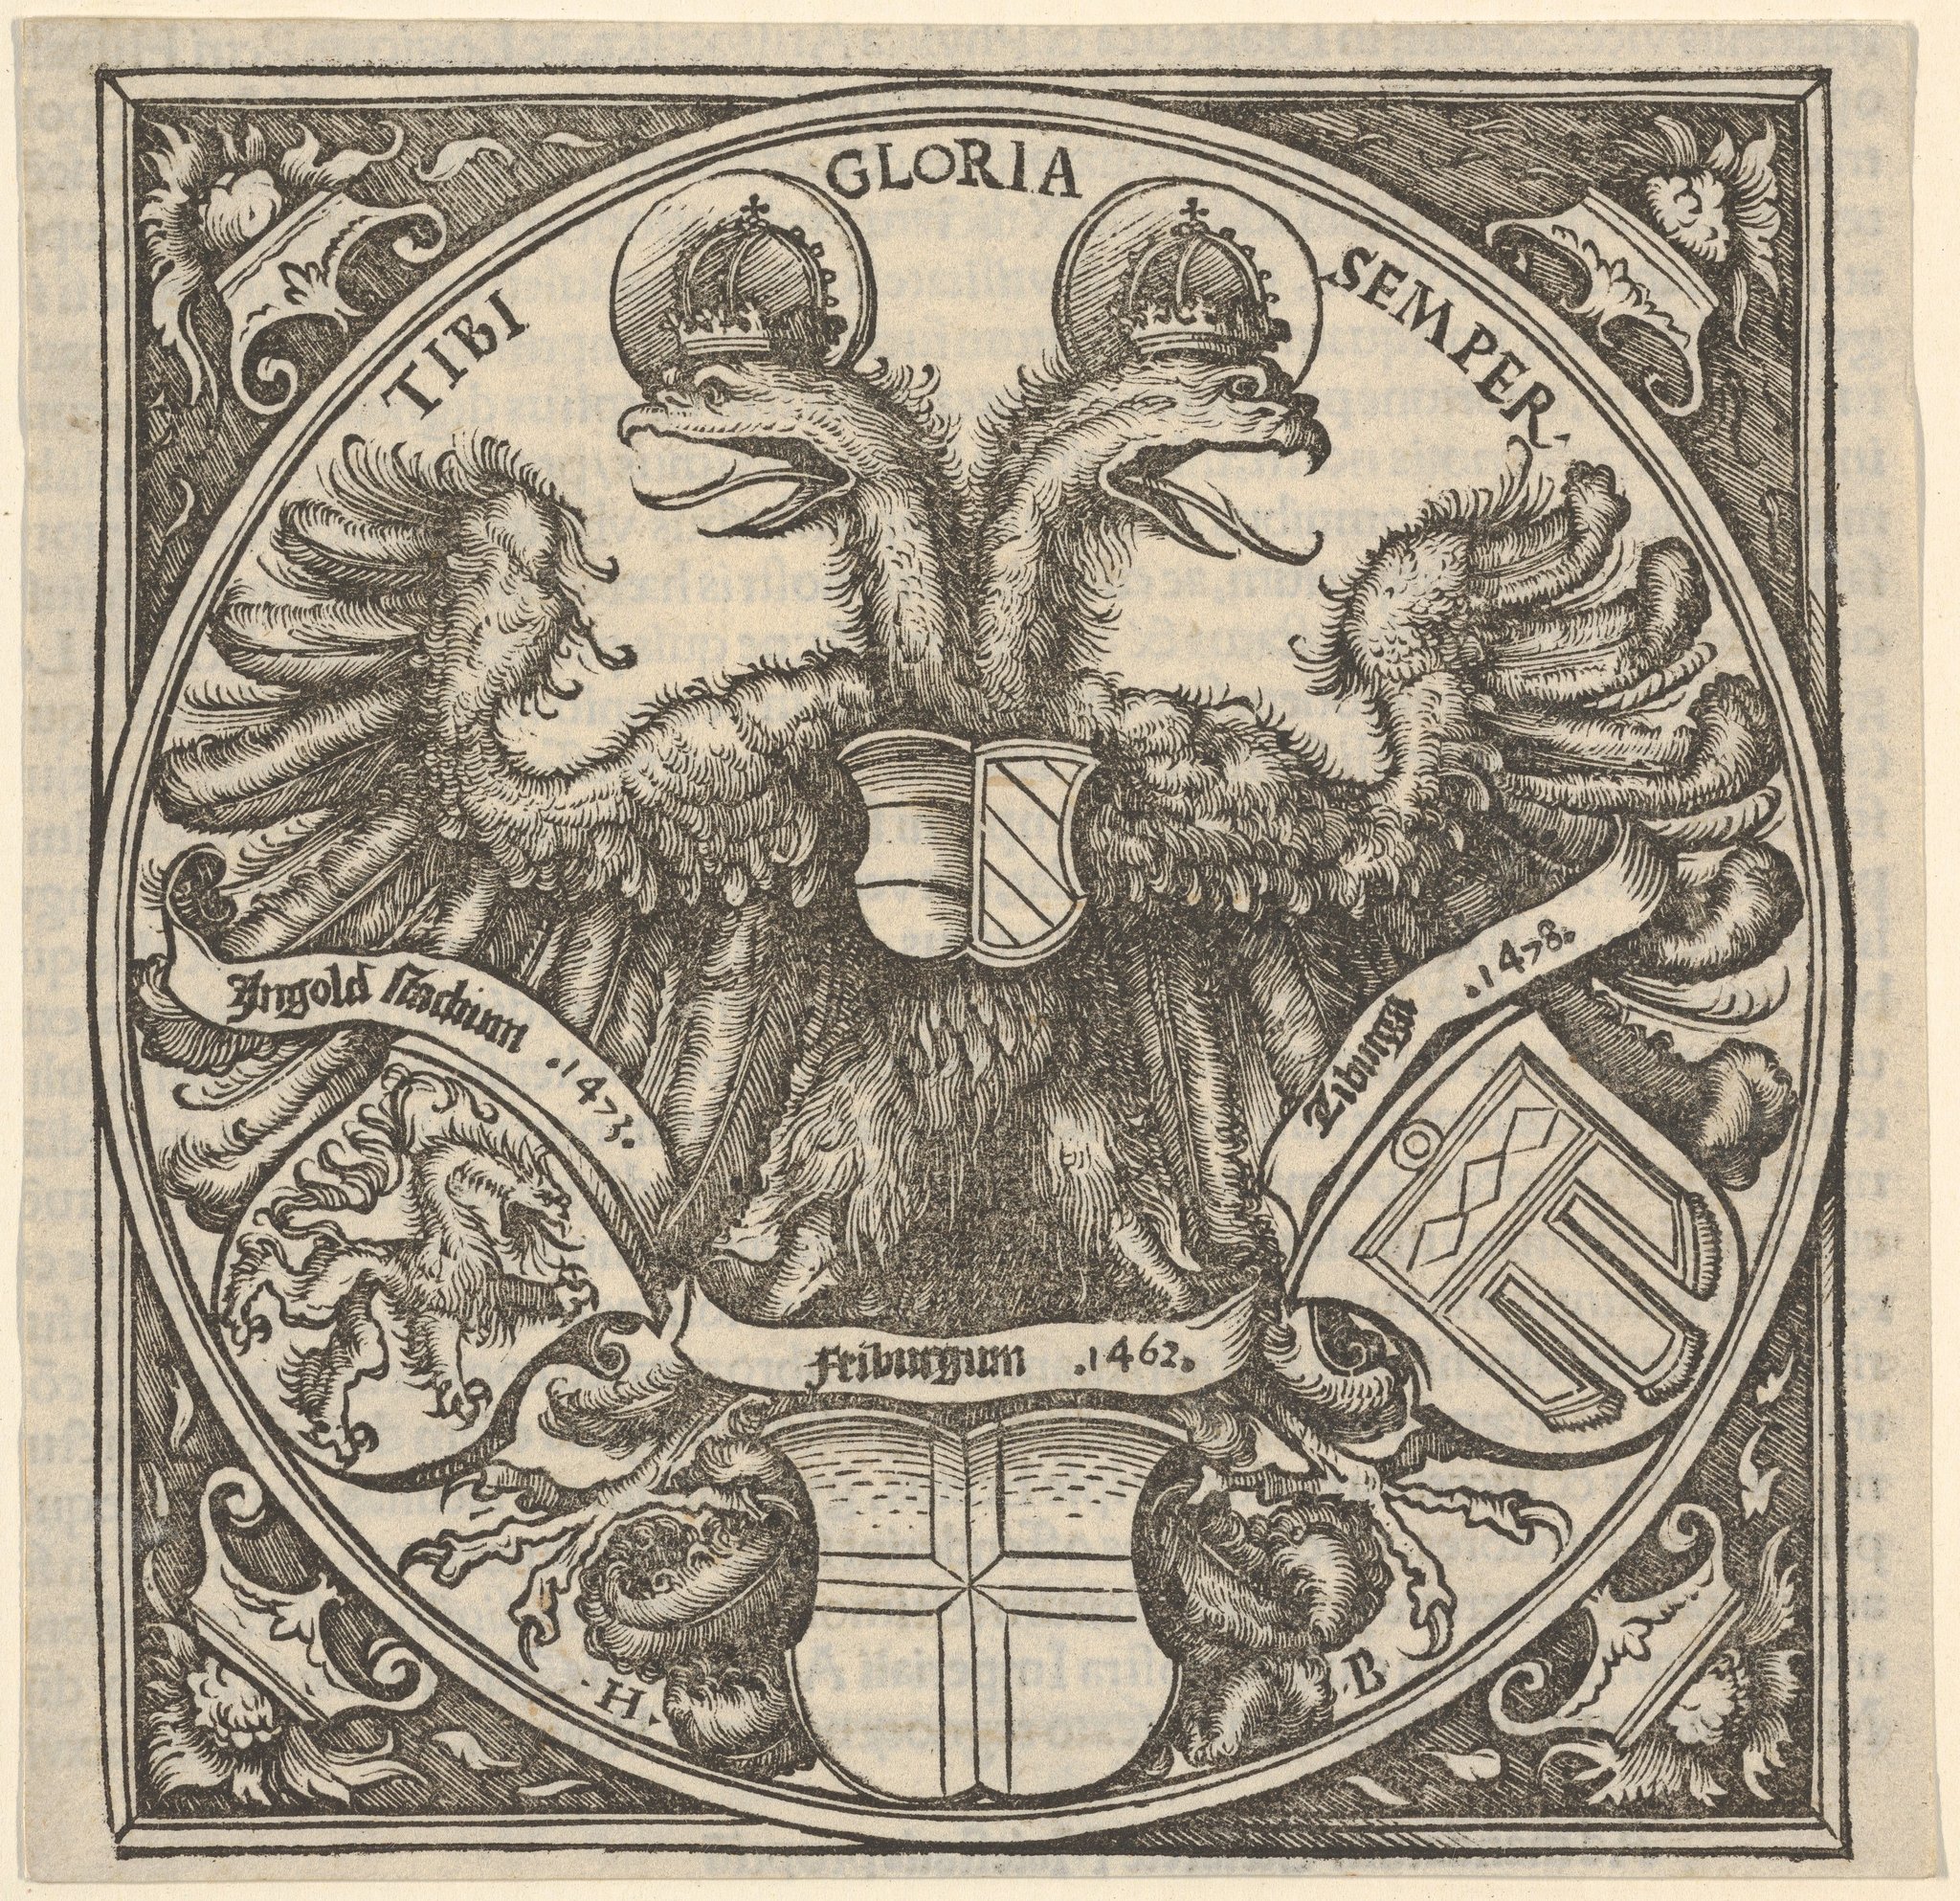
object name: print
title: Imperial Double Eagle with the Coat of Arms of Ingolstadt, Freiburg, and Tübingen, from Joan. Eckii Theologi in summulas Petri Hispani extemporaria et succincta atque succosa explanatio p[ro] sup[er] ioris Germaniae scholasticis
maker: hans burgkmair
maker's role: artist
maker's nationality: german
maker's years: 1473-1531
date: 1516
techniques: woodcut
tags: eagles,coat of arms